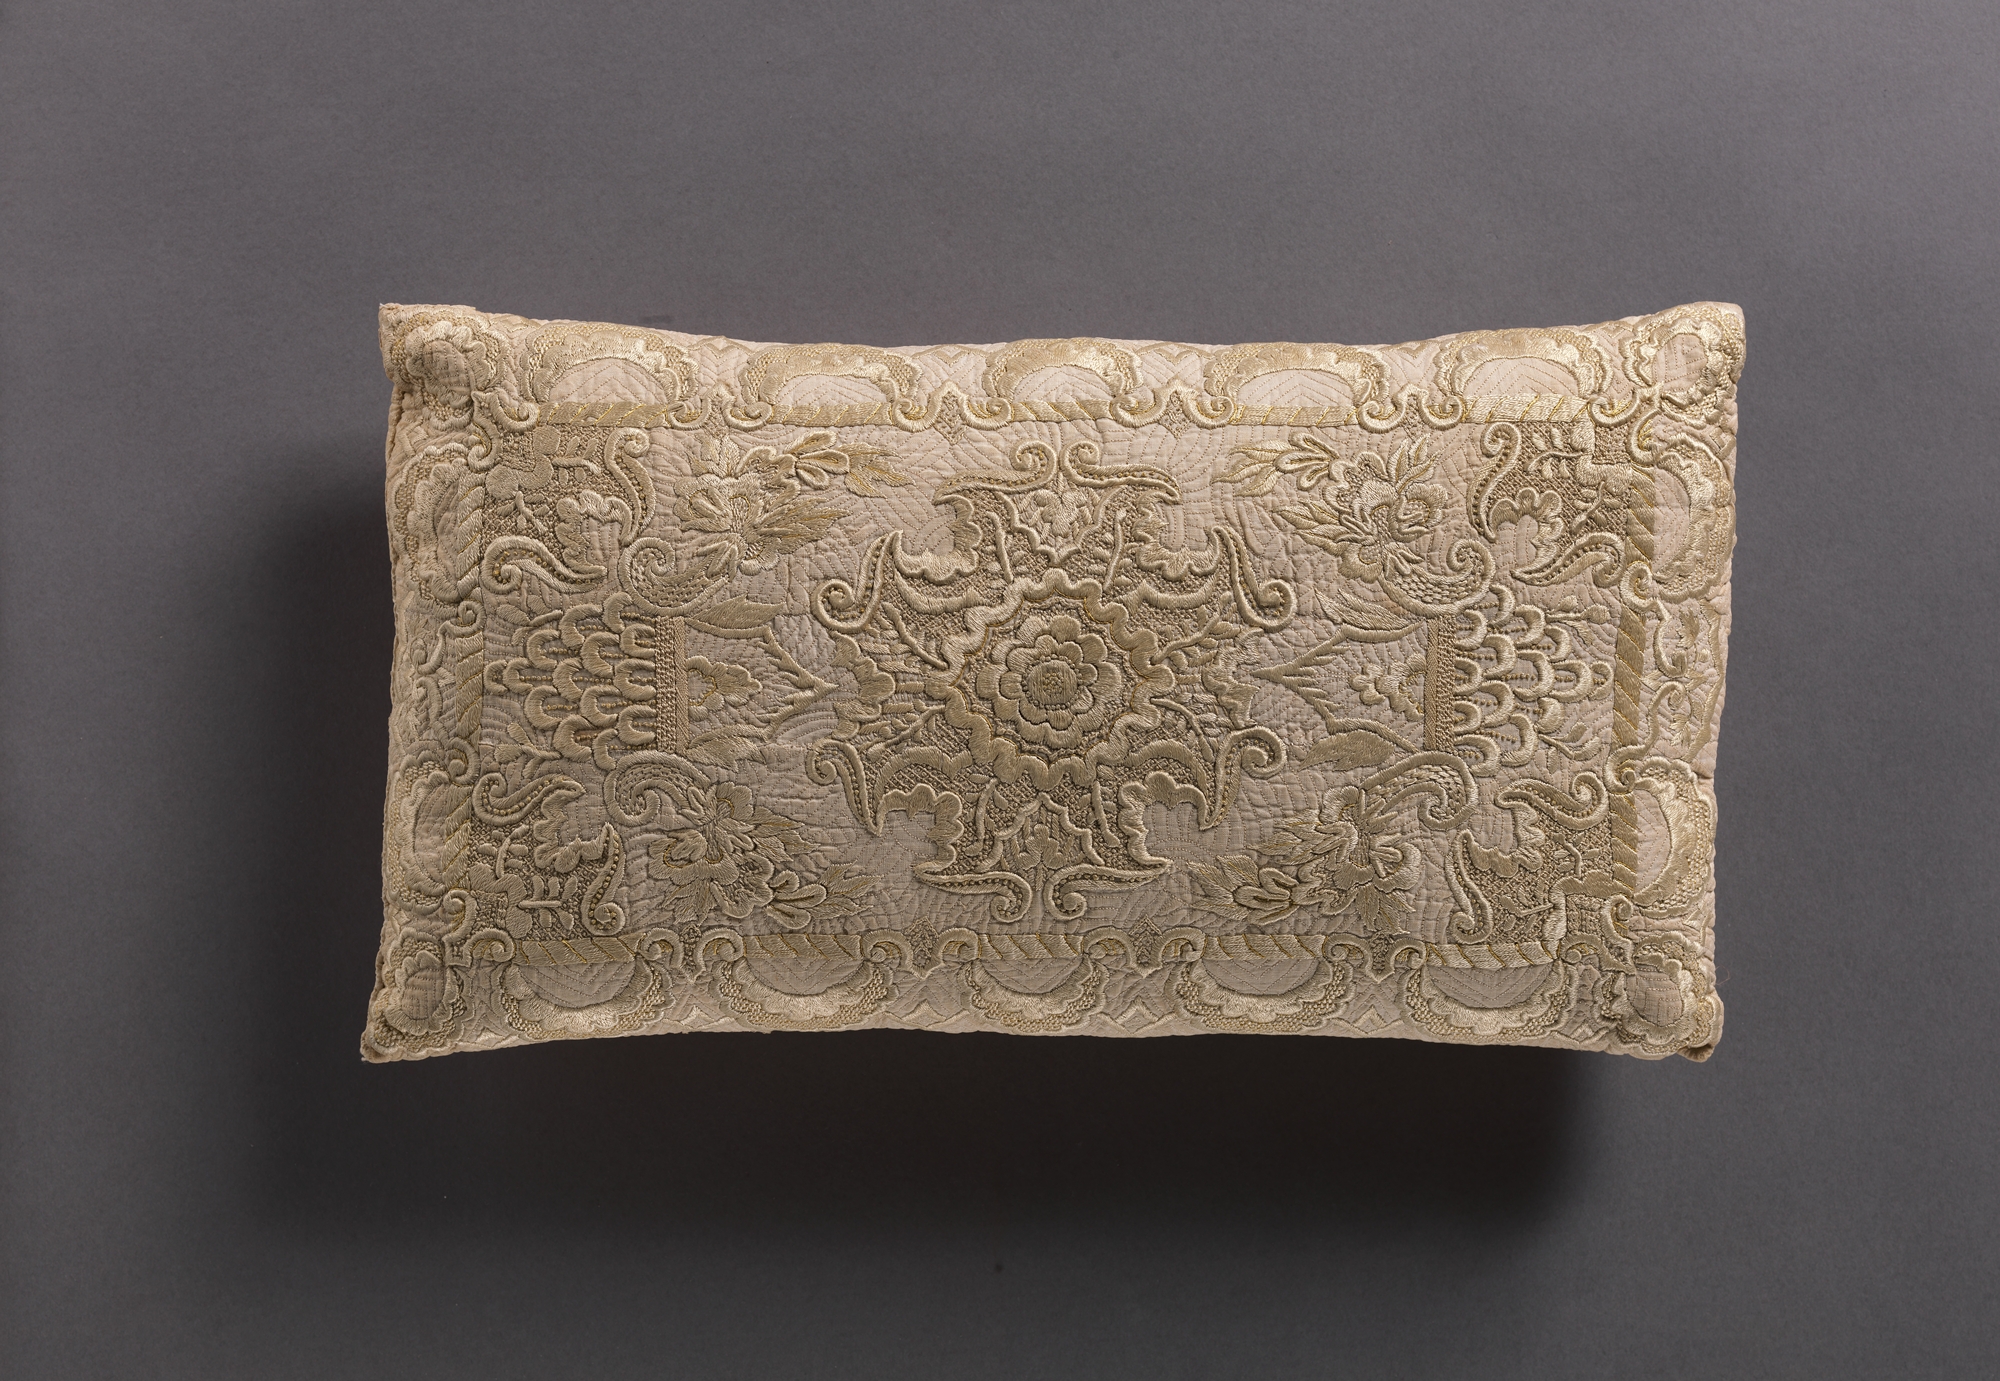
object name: pillow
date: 1667-1700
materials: cotton, silk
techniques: embroidery